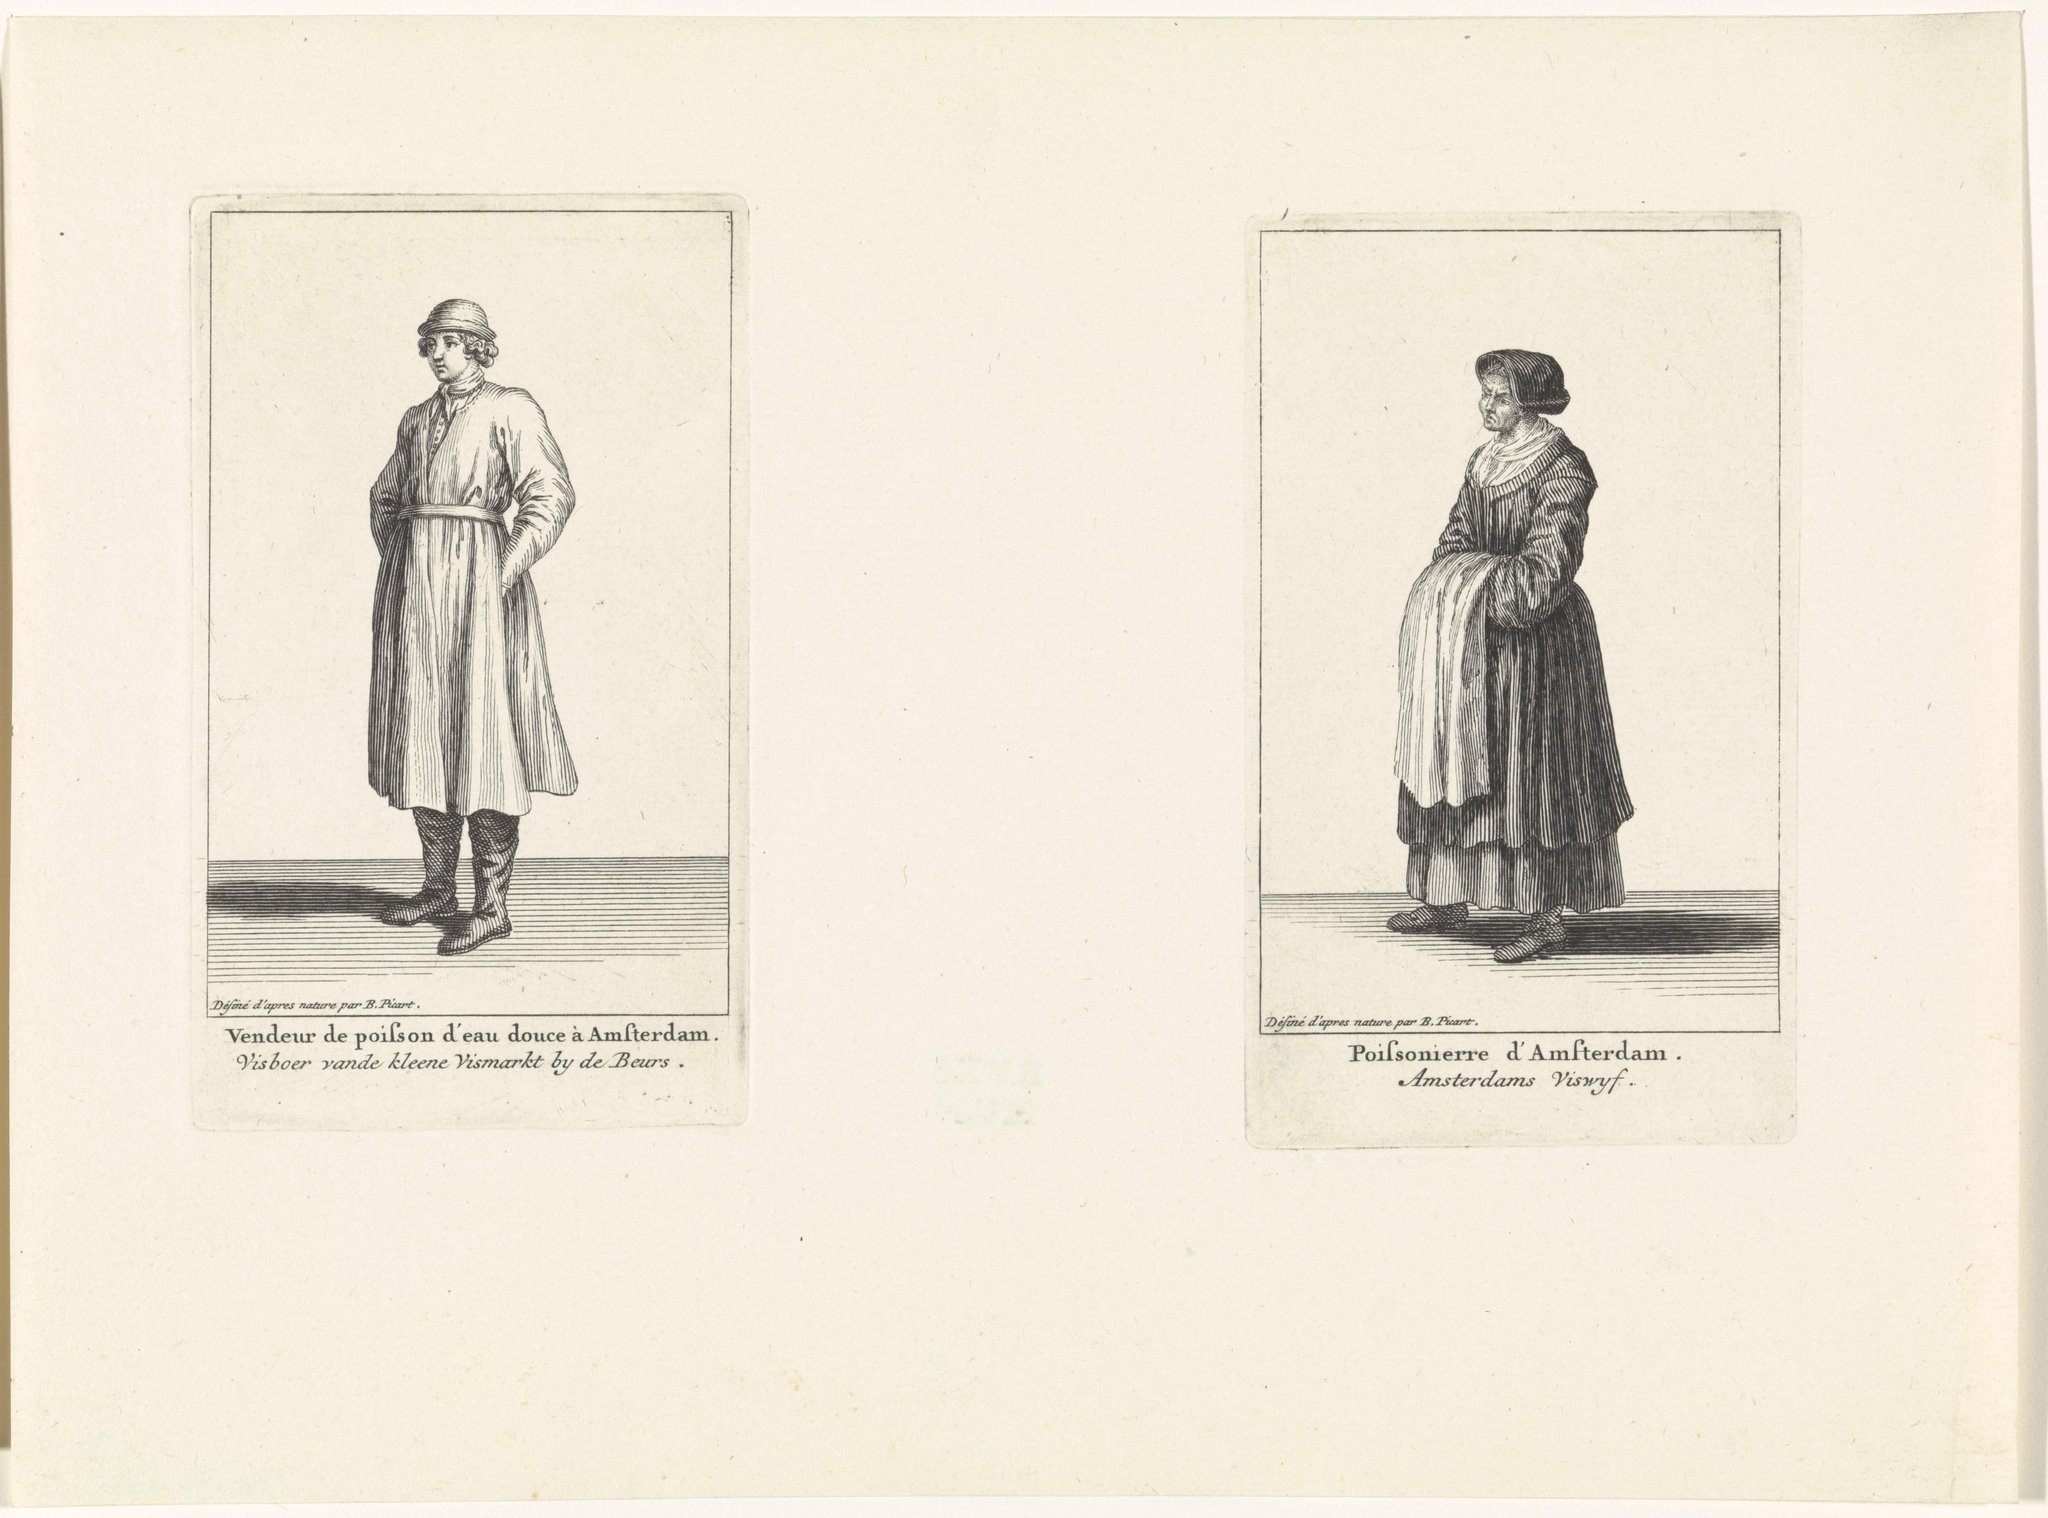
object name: costume print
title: Amsterdamse visboer en Amsterdams viswijf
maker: bernard picart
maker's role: draughtsman, print maker, publisher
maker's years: 1673-1733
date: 1728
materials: paper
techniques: engraving, etching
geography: amsterdam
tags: folk costume, regional costume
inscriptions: collector's mark: Lugt 2165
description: Onversneden blad met twee prenten met voorstellingen van figuren in klederdracht. De prenten hebben een titel in het Frans en in het Nederlands.